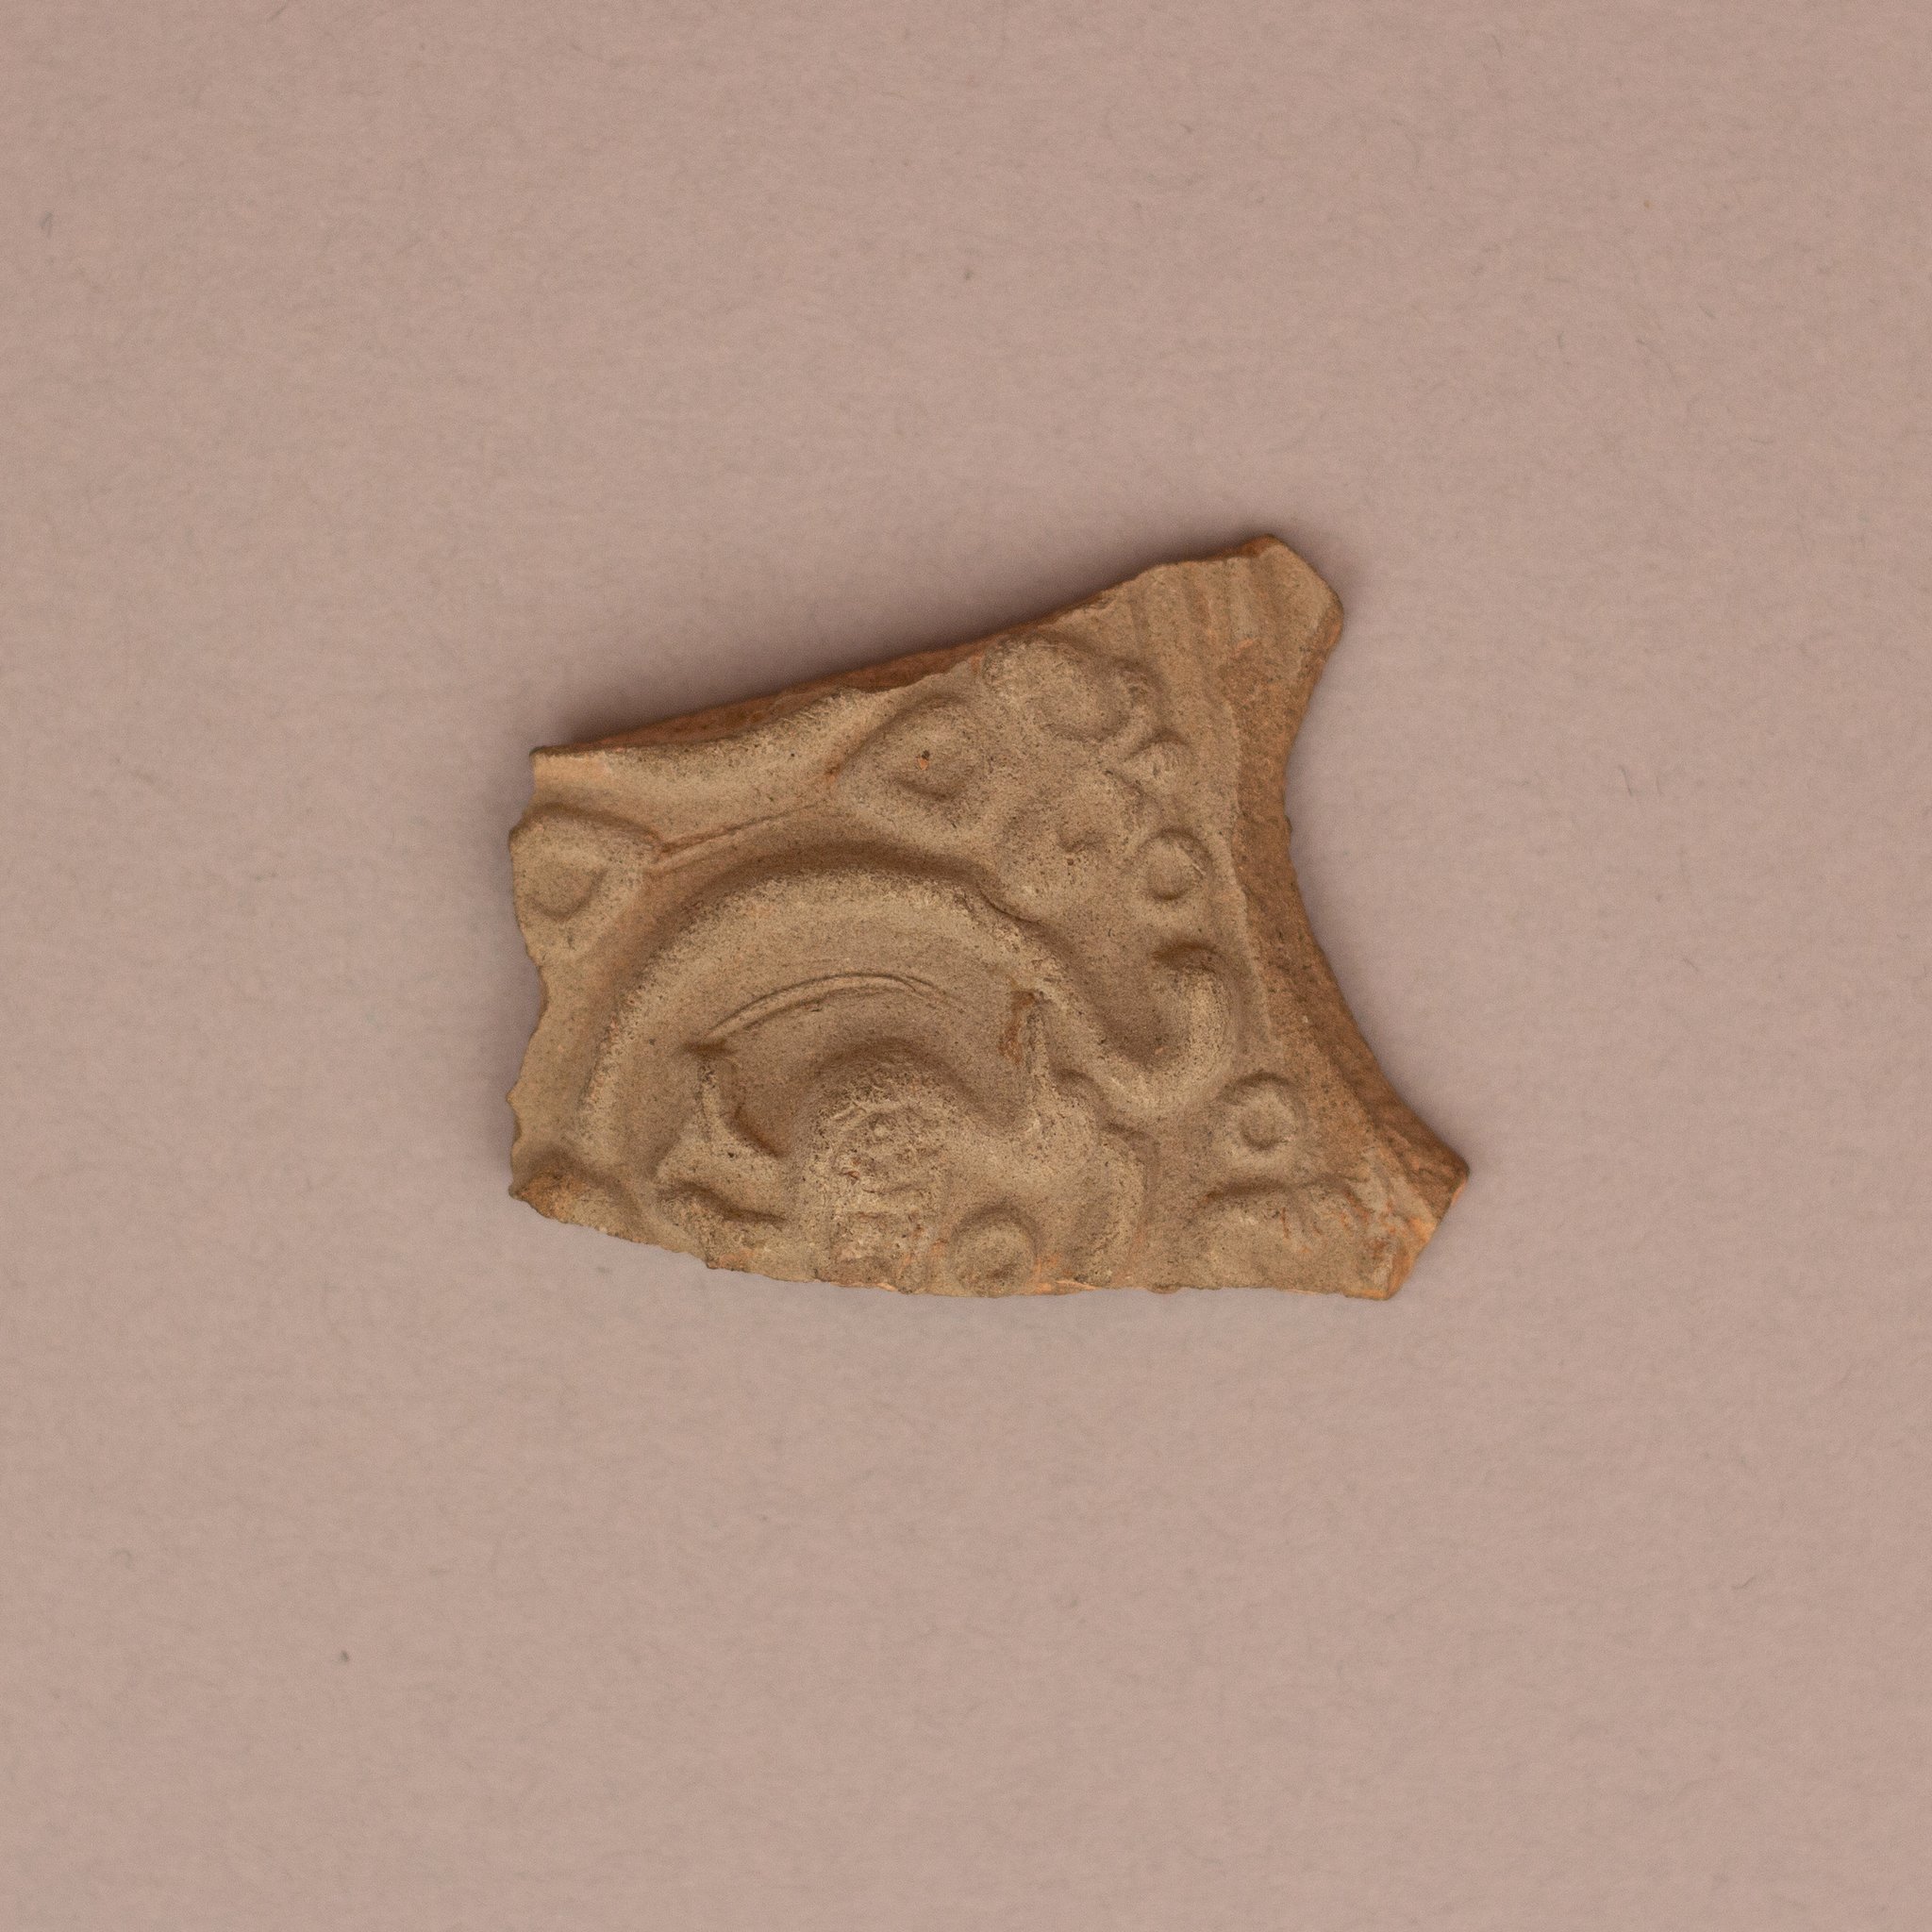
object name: fragment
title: Ceramic Fragment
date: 1001-1200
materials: earthenware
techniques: molding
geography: iran